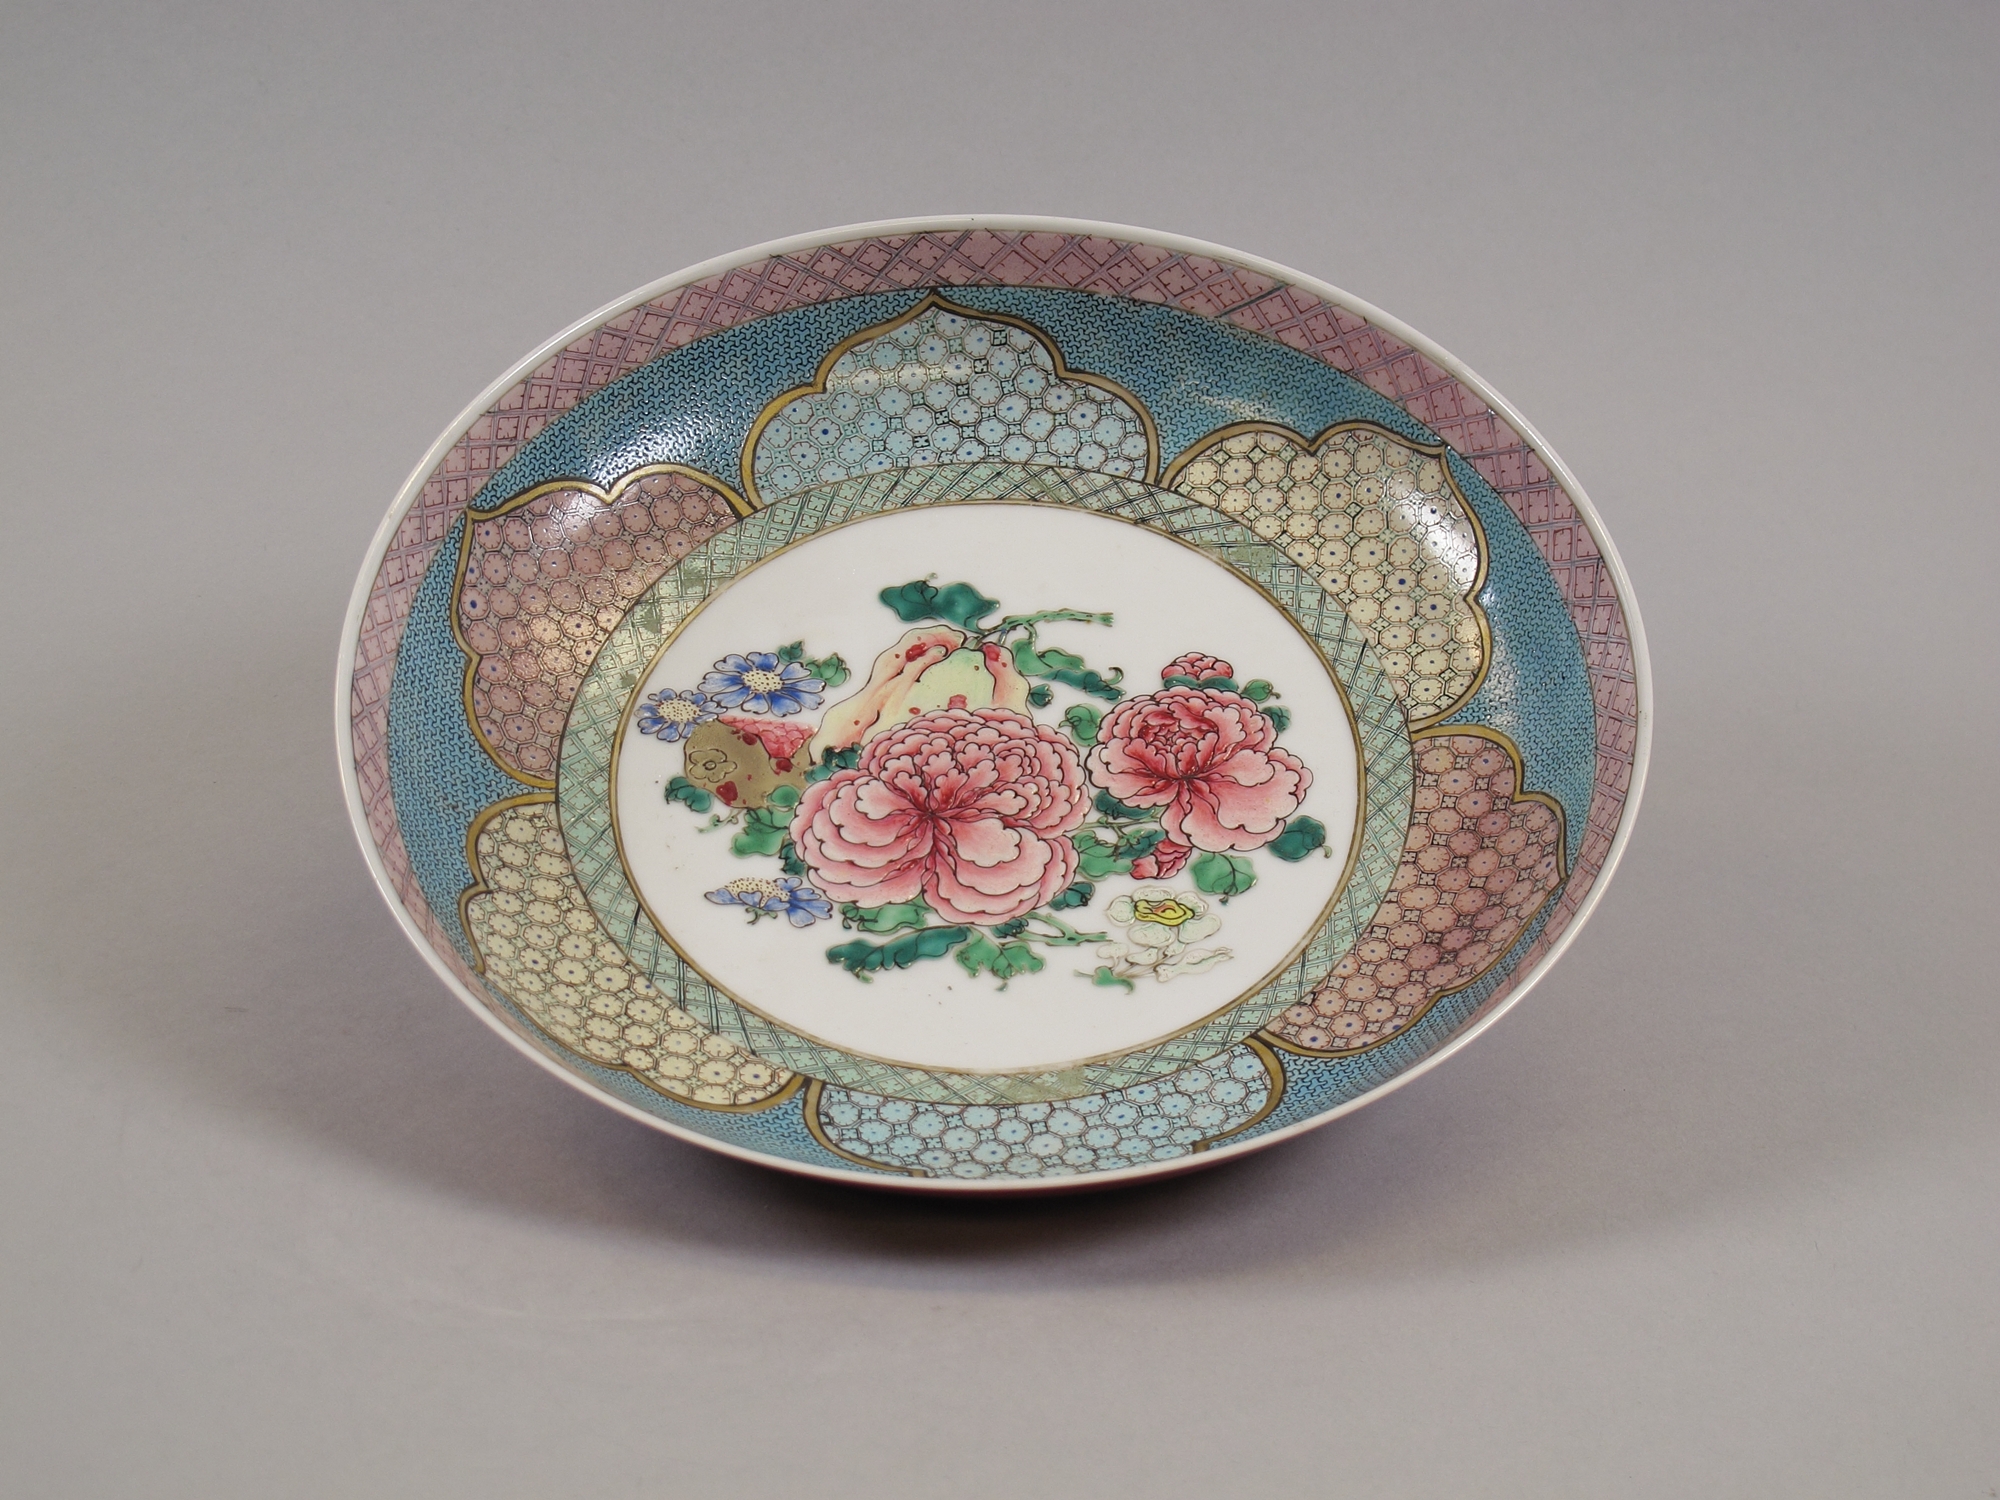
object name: dish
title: Dish with flowers and fruits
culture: chinese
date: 1730-1750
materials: enamel, porcelain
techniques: overglaze, painting, polychrome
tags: flowers